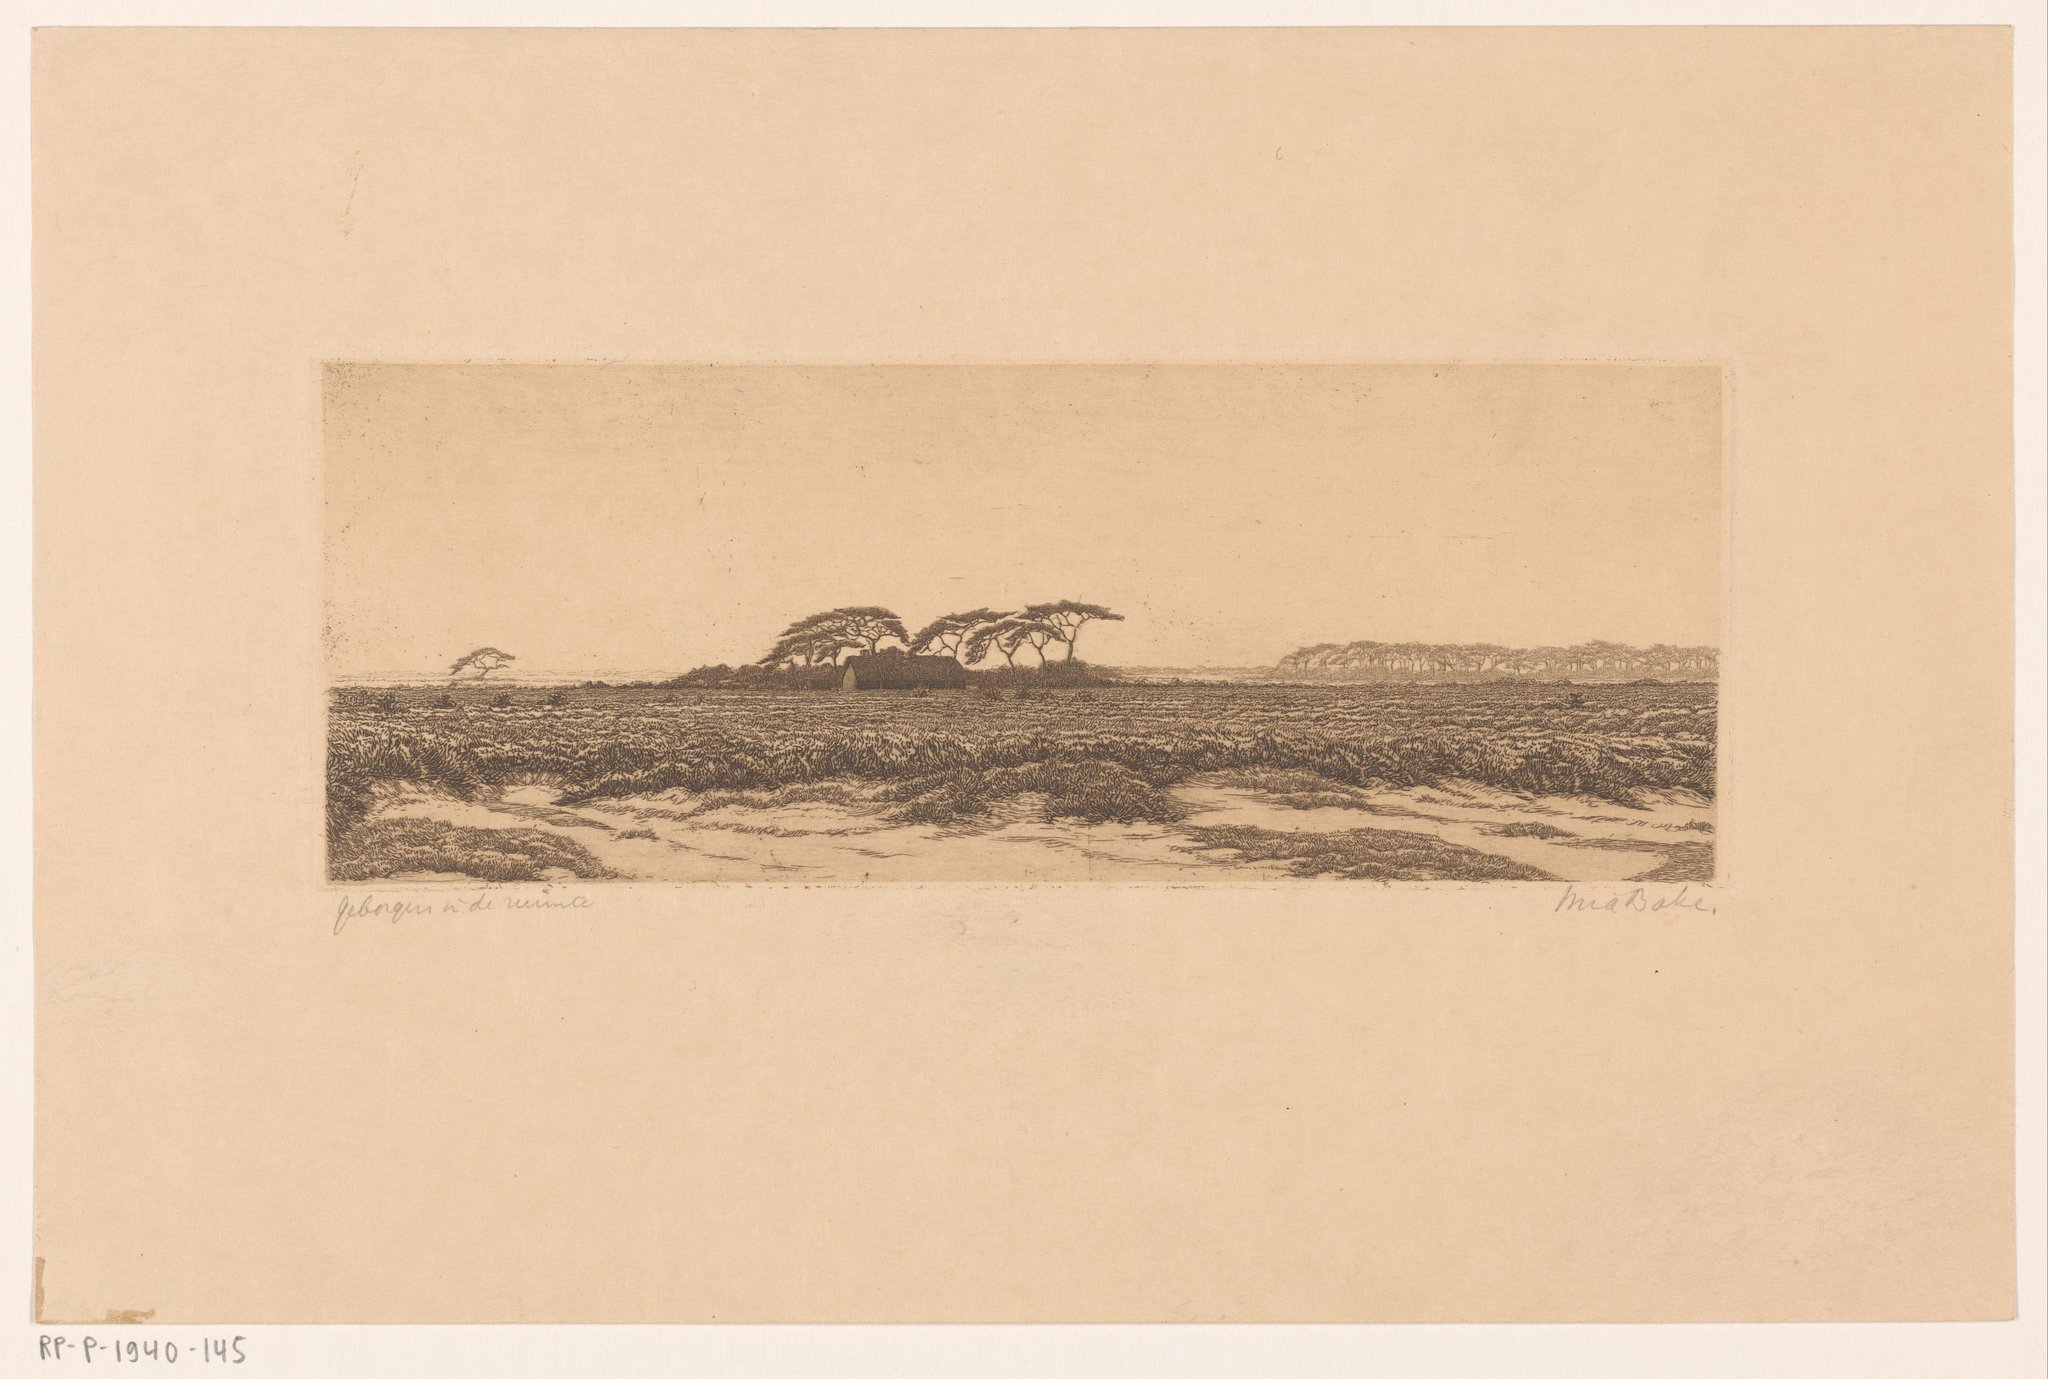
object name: print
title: Geborgen in de ruimte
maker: mia bake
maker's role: draughtsman, print maker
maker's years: 1886-1939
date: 1896-1939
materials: paper, ink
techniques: aquatint, drypoint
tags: farm or solitary house in landscape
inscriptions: collector's mark: Lugt L.2166, title: ‘geborgen in de ruimte’, signature: ‘Mia Bake’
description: Boerderij in een heidelandschap, beschut door bomen.